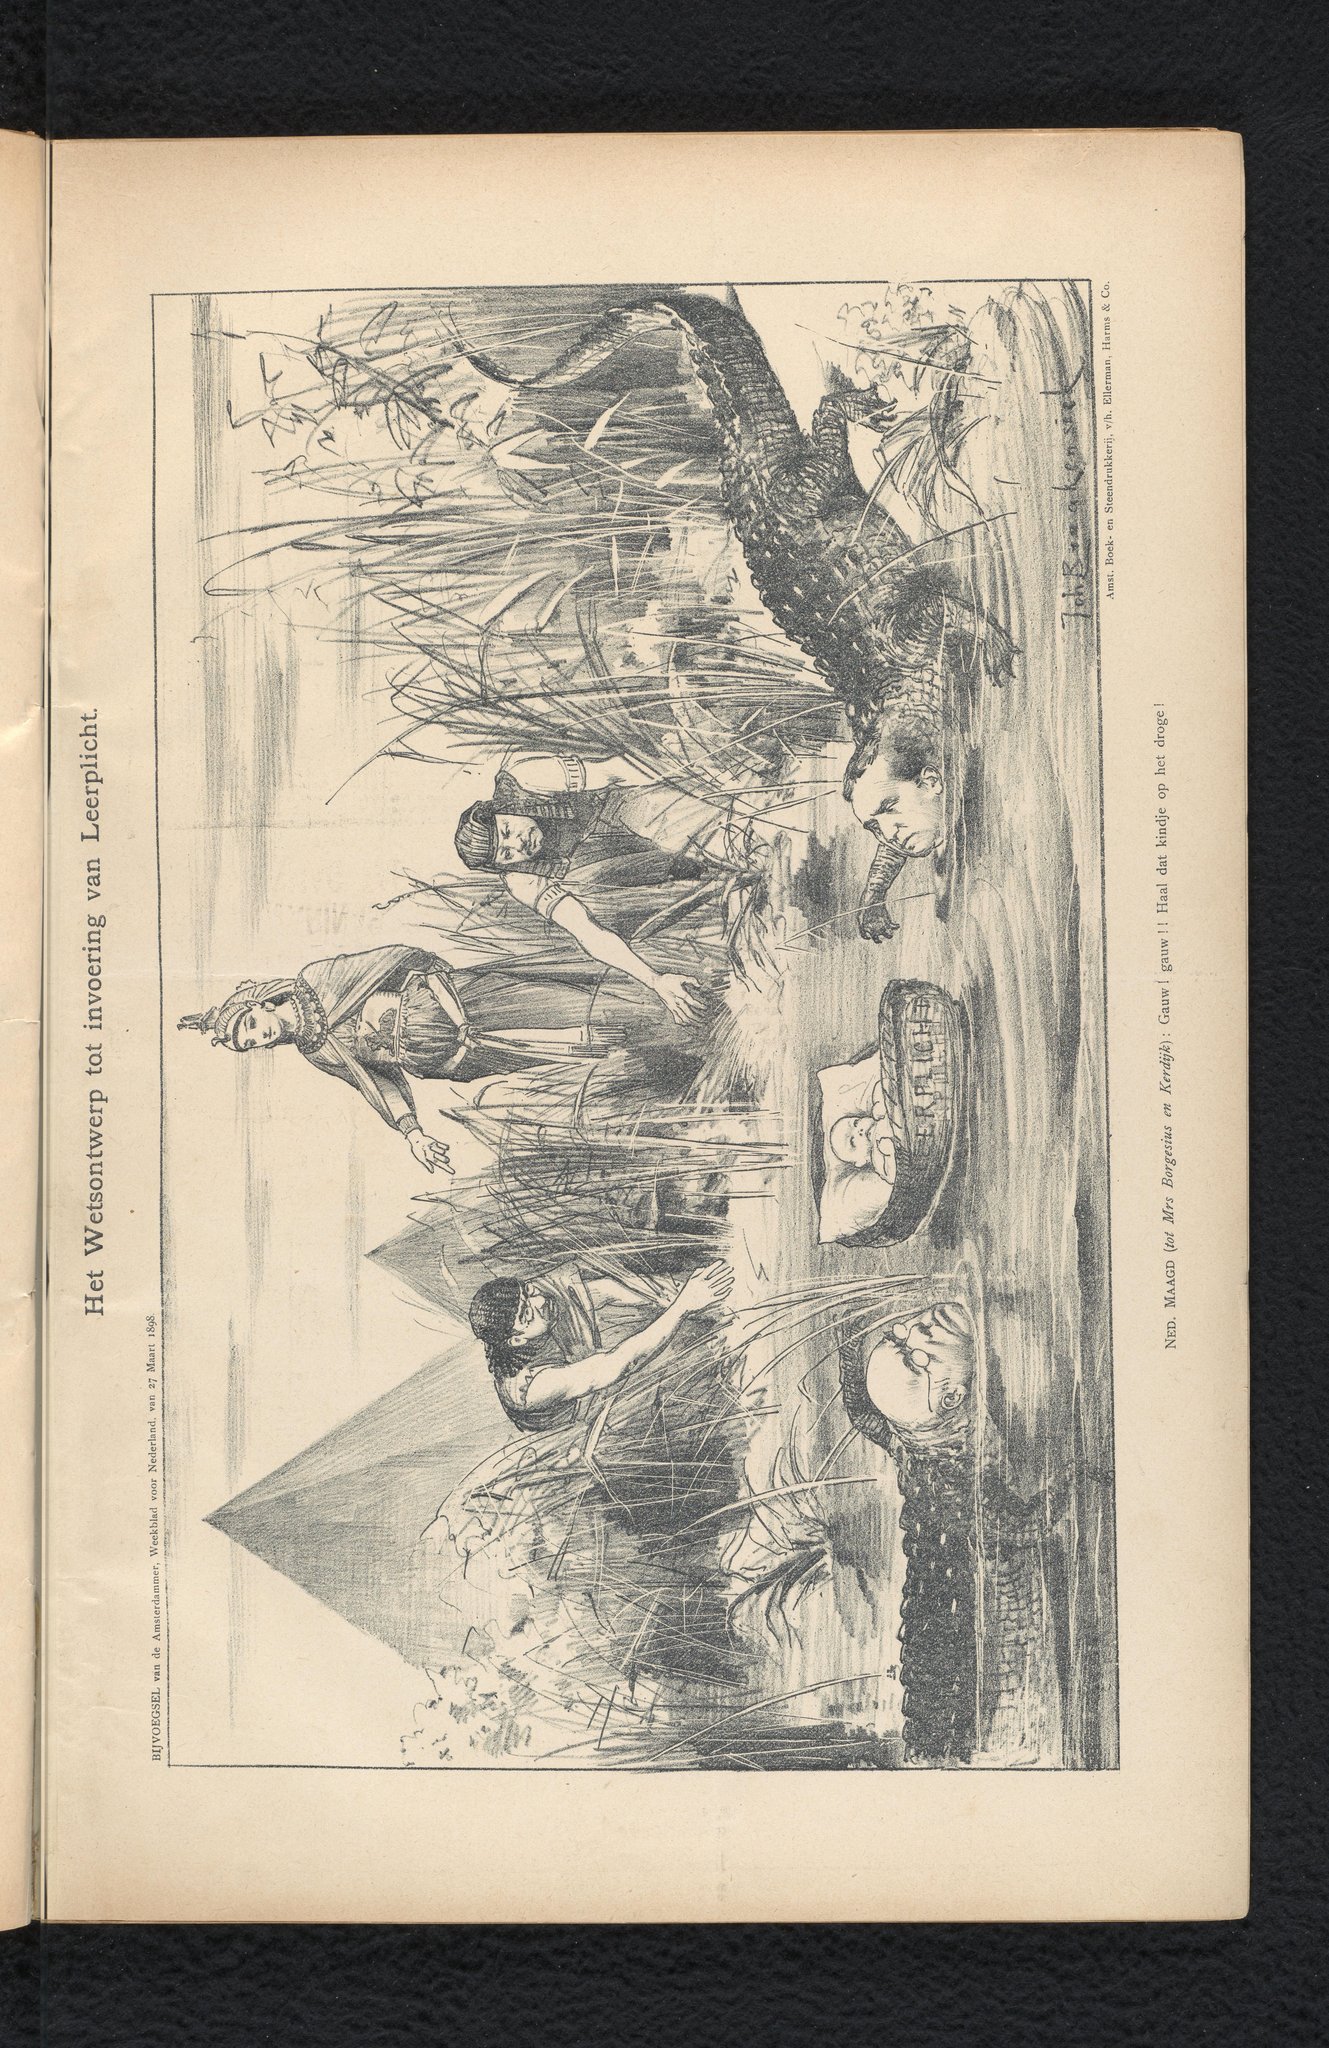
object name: cartoon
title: Het Wetsontwerp tot invoering van Leerplicht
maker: johan braakensiek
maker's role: draughtsman, print maker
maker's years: 1858-1940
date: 1898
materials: paper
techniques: lithograph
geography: amsterdam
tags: the hague, politician, abraham kuyper, rome, priest, herman johannes aloysius maria schaepman, personifications of countries, nations, states, districts, etc., crocodiles: crocodile, the finding of moses: pharaoh's daughter comes to bathe with her maidens in the river and discovers the child floating on the water, scholastic education, tuition, political caricatures and satires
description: De Nederlandse Maagd als de dochter van Farao die Mozes in het biezenmandje vindt. Zij laat minister Borgesius en kamerlid Kerdijk met mandje 'leerplicht' uit het water halen voordat de krokodillen Schaepman en Kuyper het bereiken.